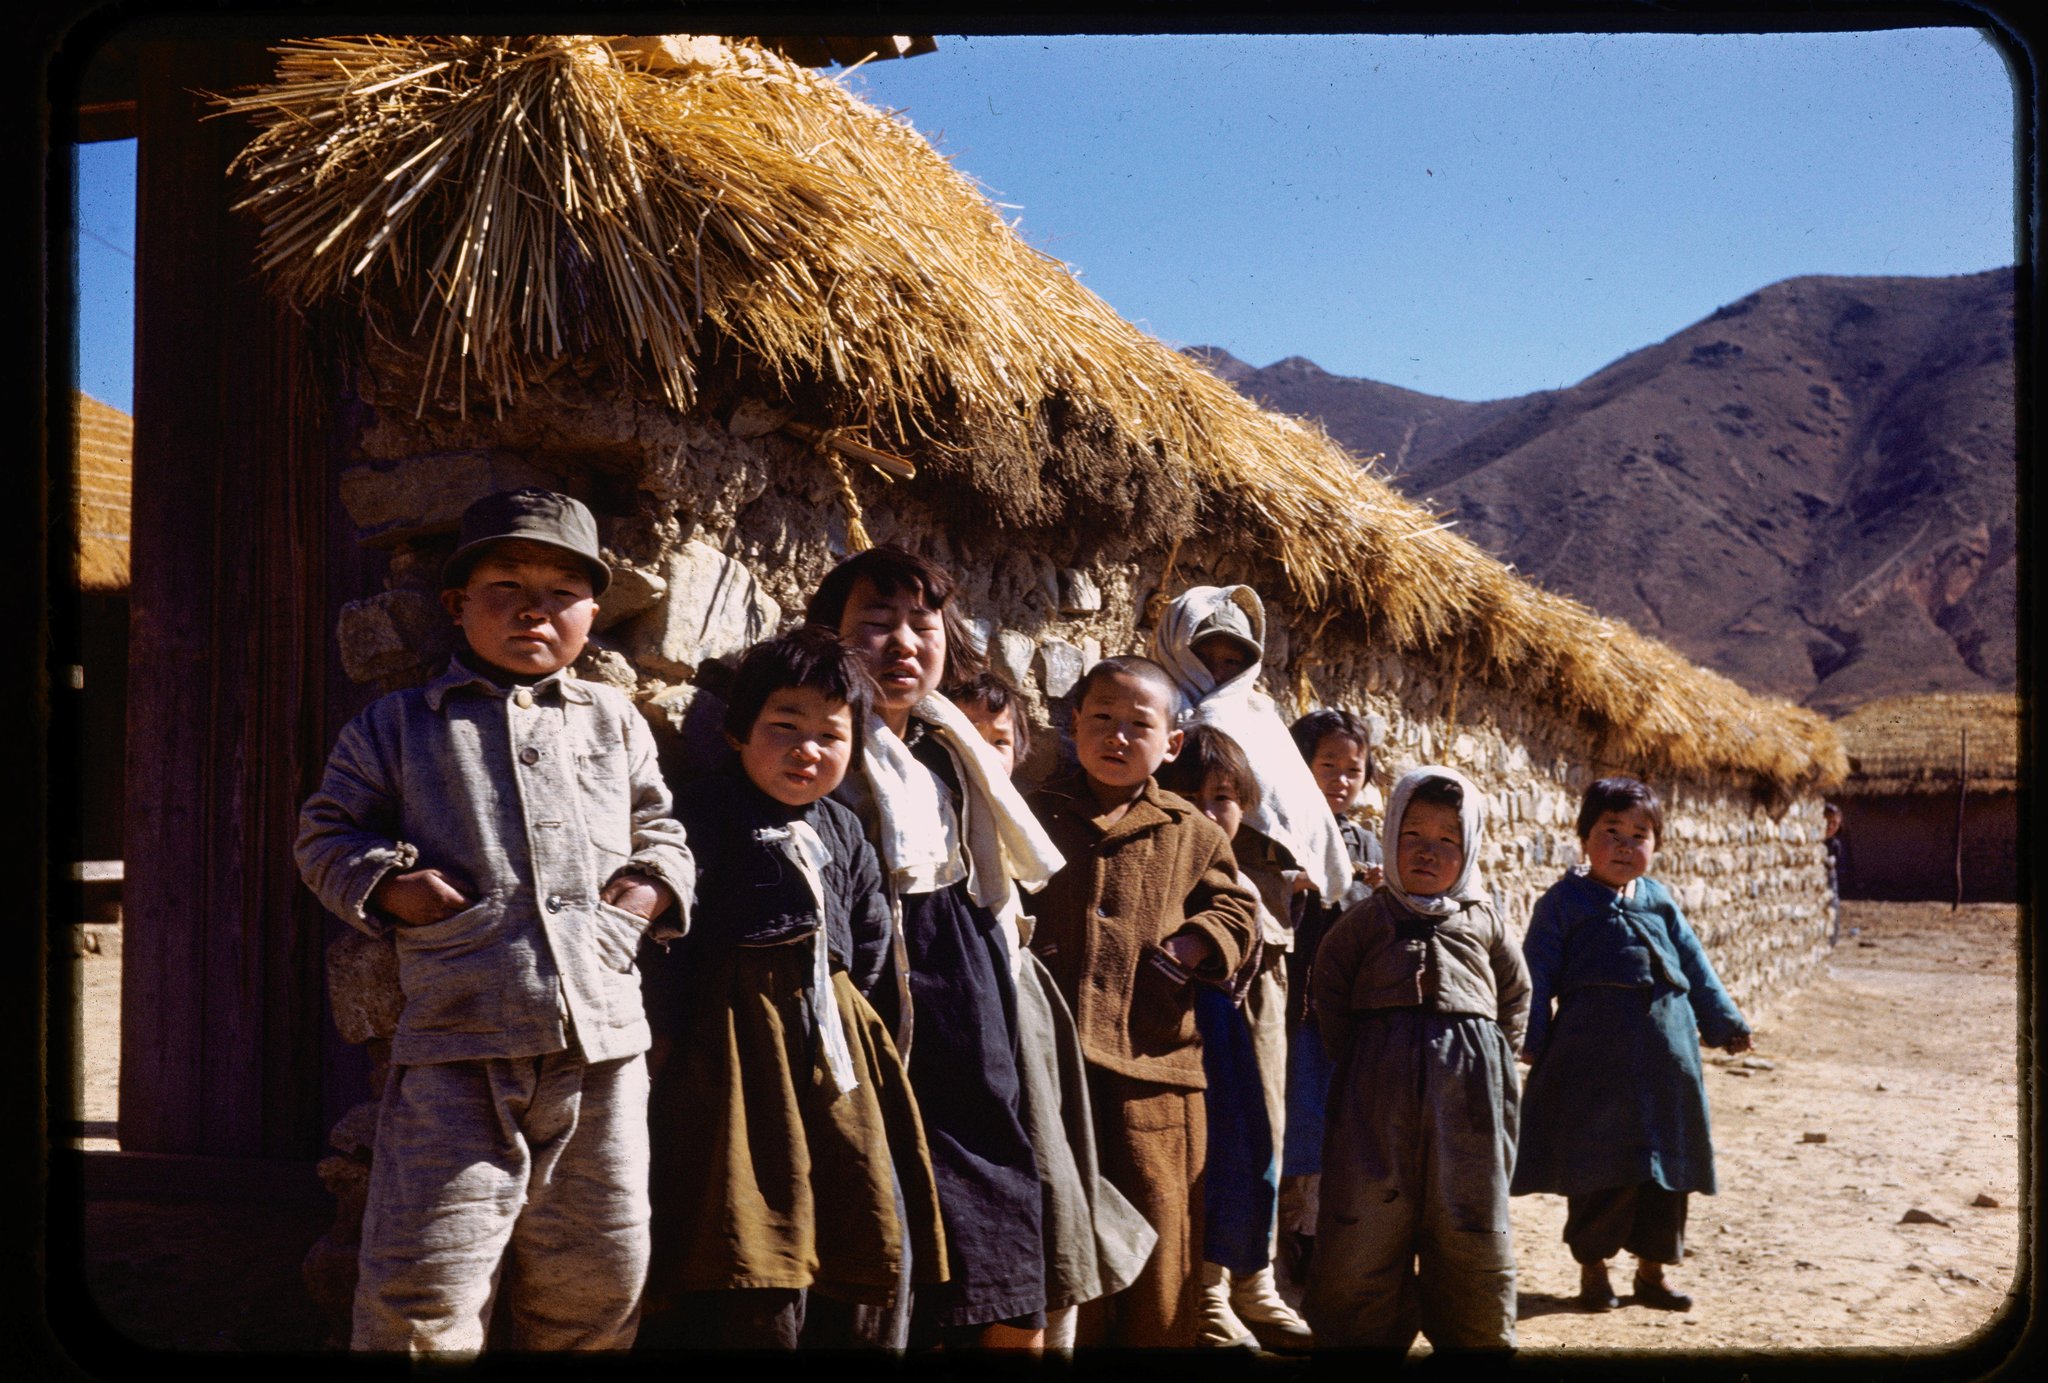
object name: color slide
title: Oorlog in Korea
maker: david ketel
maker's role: diplomaat, sinoloog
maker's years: 1913-2008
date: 1950-1951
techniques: slide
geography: korea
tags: united nations